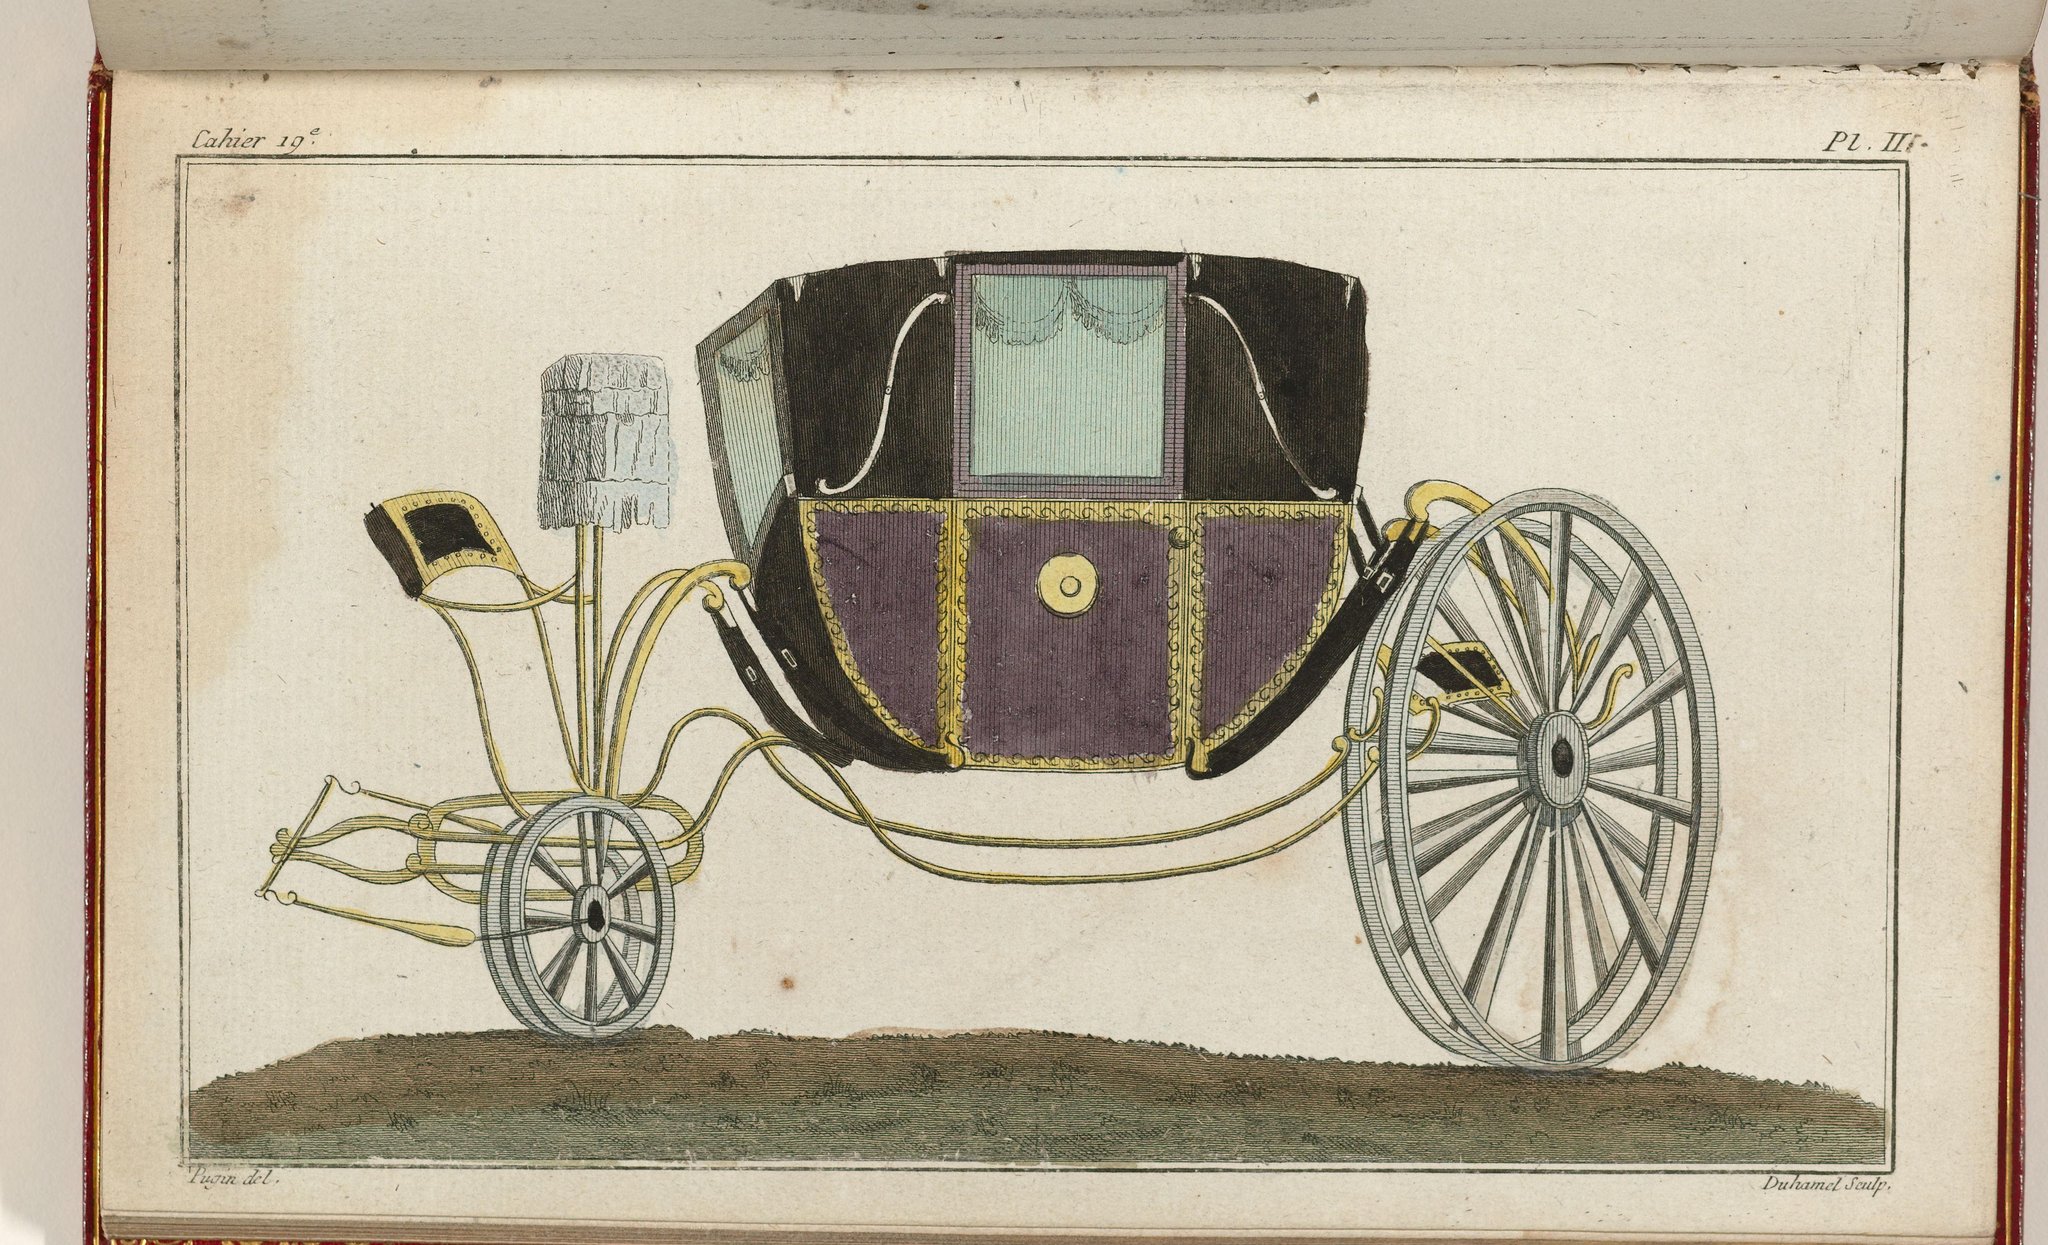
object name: print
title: Cabinet des Modes ou les Modes Nouvelles, 15 Aout 1786, pl. III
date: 1786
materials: paper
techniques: engraving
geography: paris